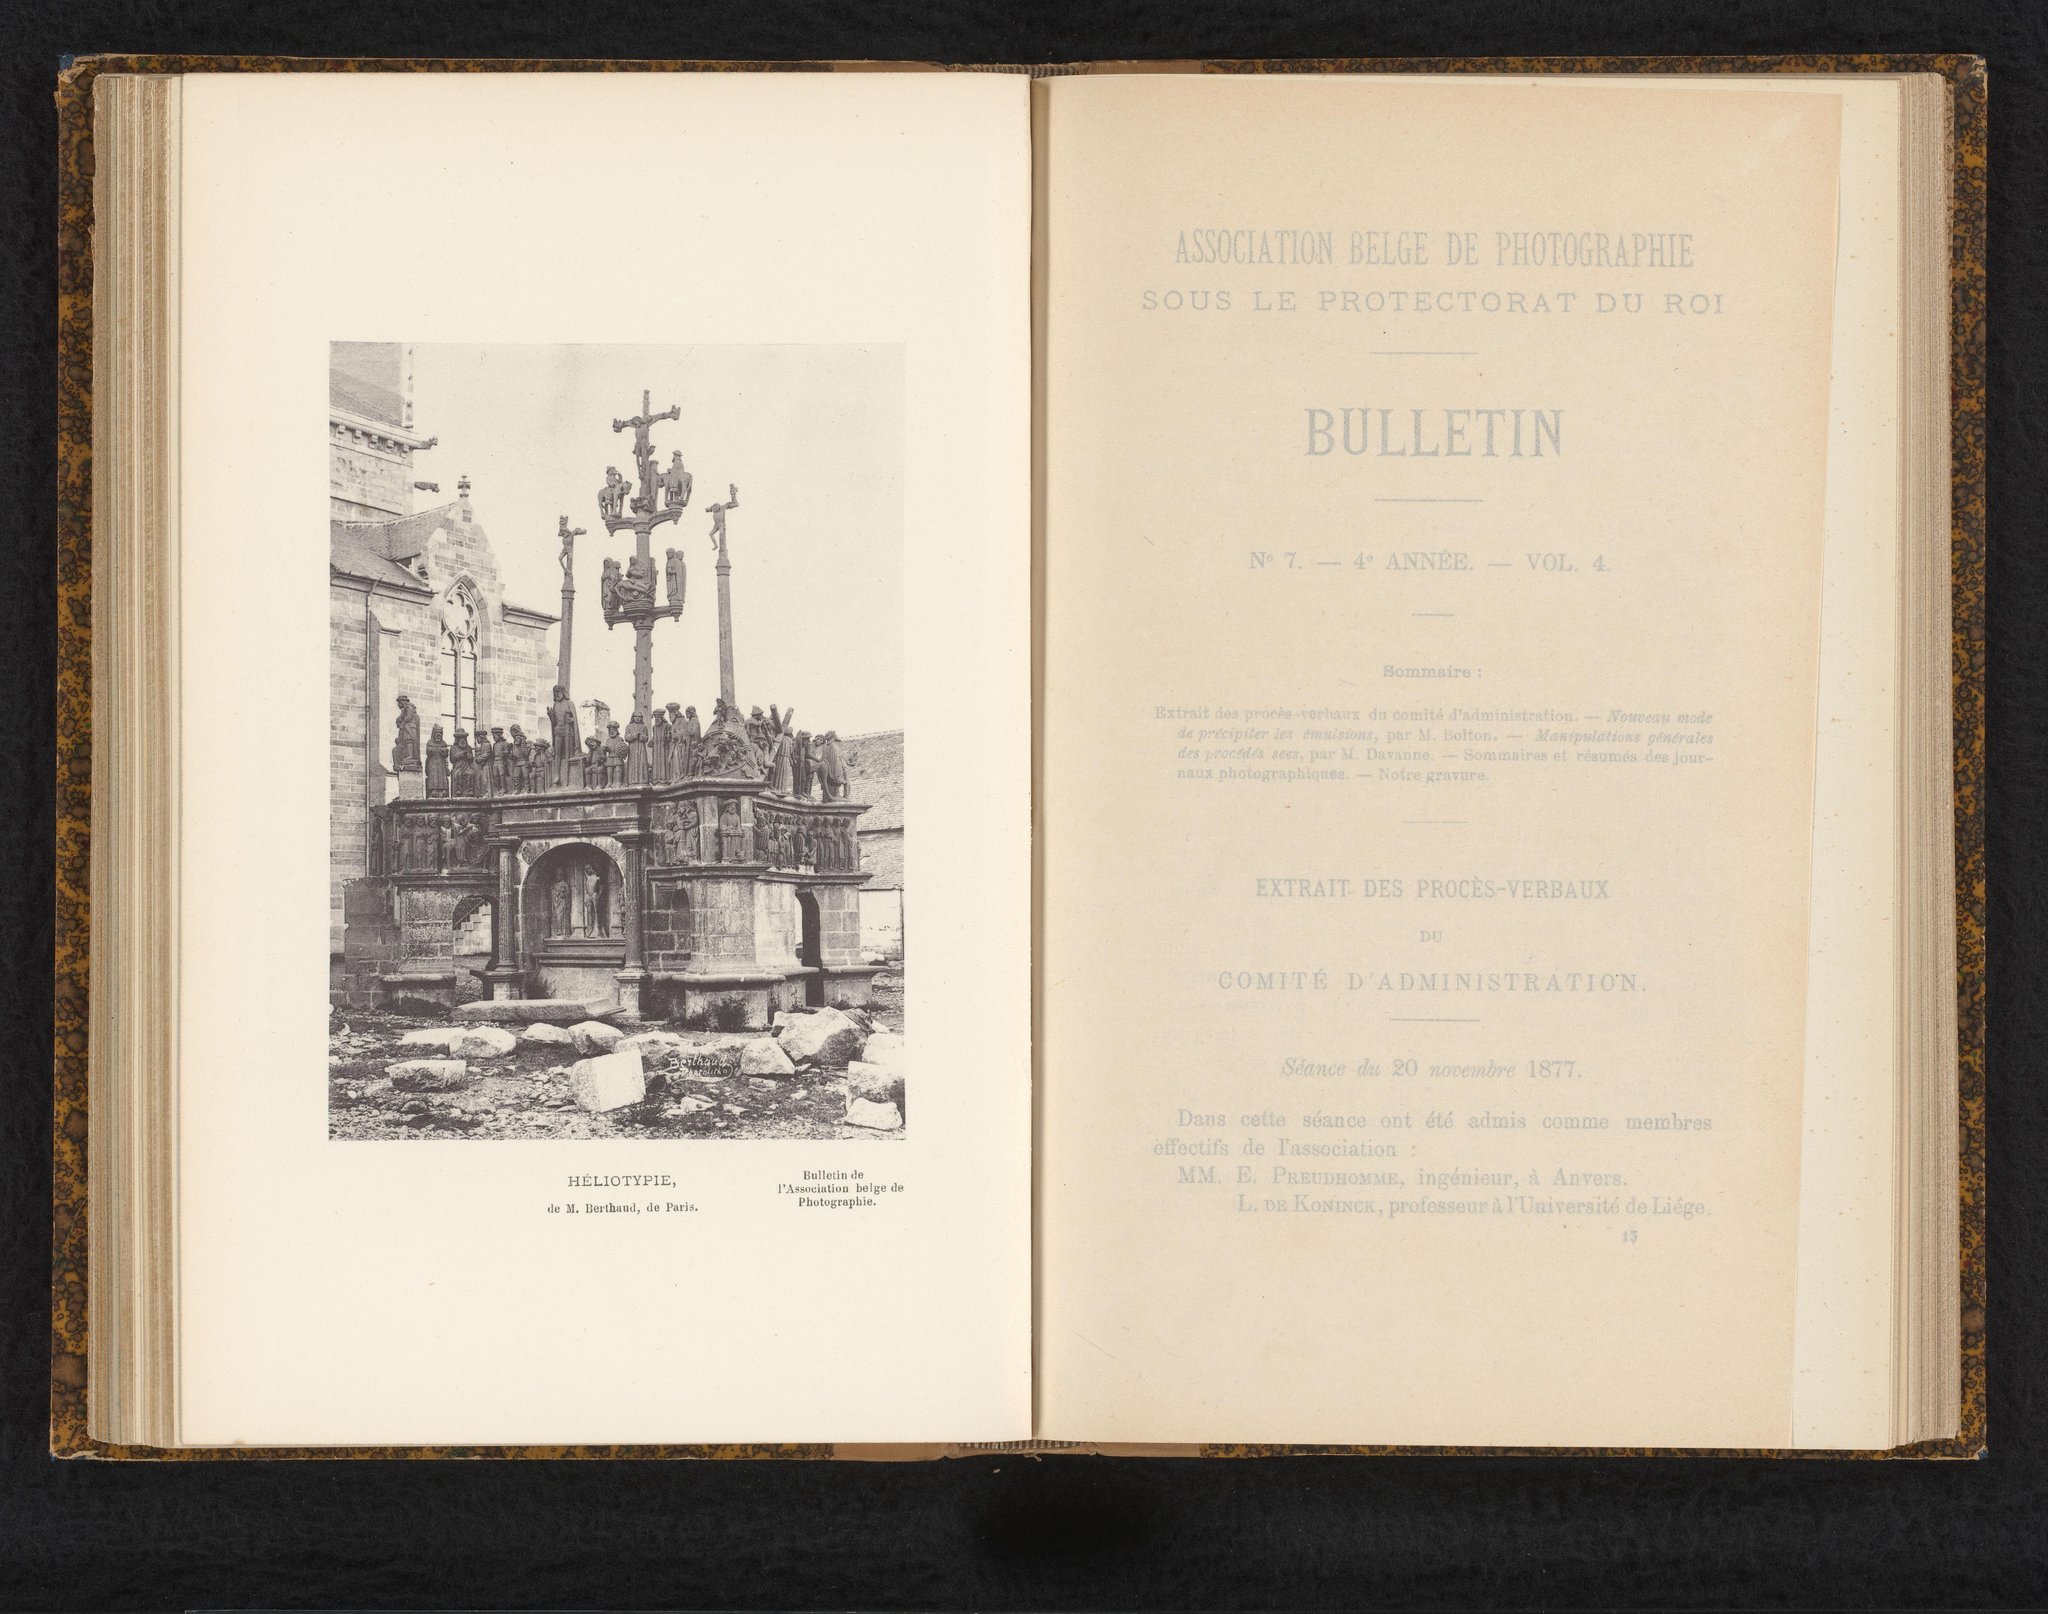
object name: photomechanical print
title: Le calvaire de Plaicastel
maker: michel berthaud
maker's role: publisher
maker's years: 1845-1912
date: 1872-1877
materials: paper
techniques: heliotype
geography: plougastel-daoulas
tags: piece of sculpture, reproduction of a piece of sculpture, crucified christ with other persons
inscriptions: inscription: ‘Héliotypie,/ de M. Berthaud, de Paris’, inscription: ‘Berthaud/ Photolitho’